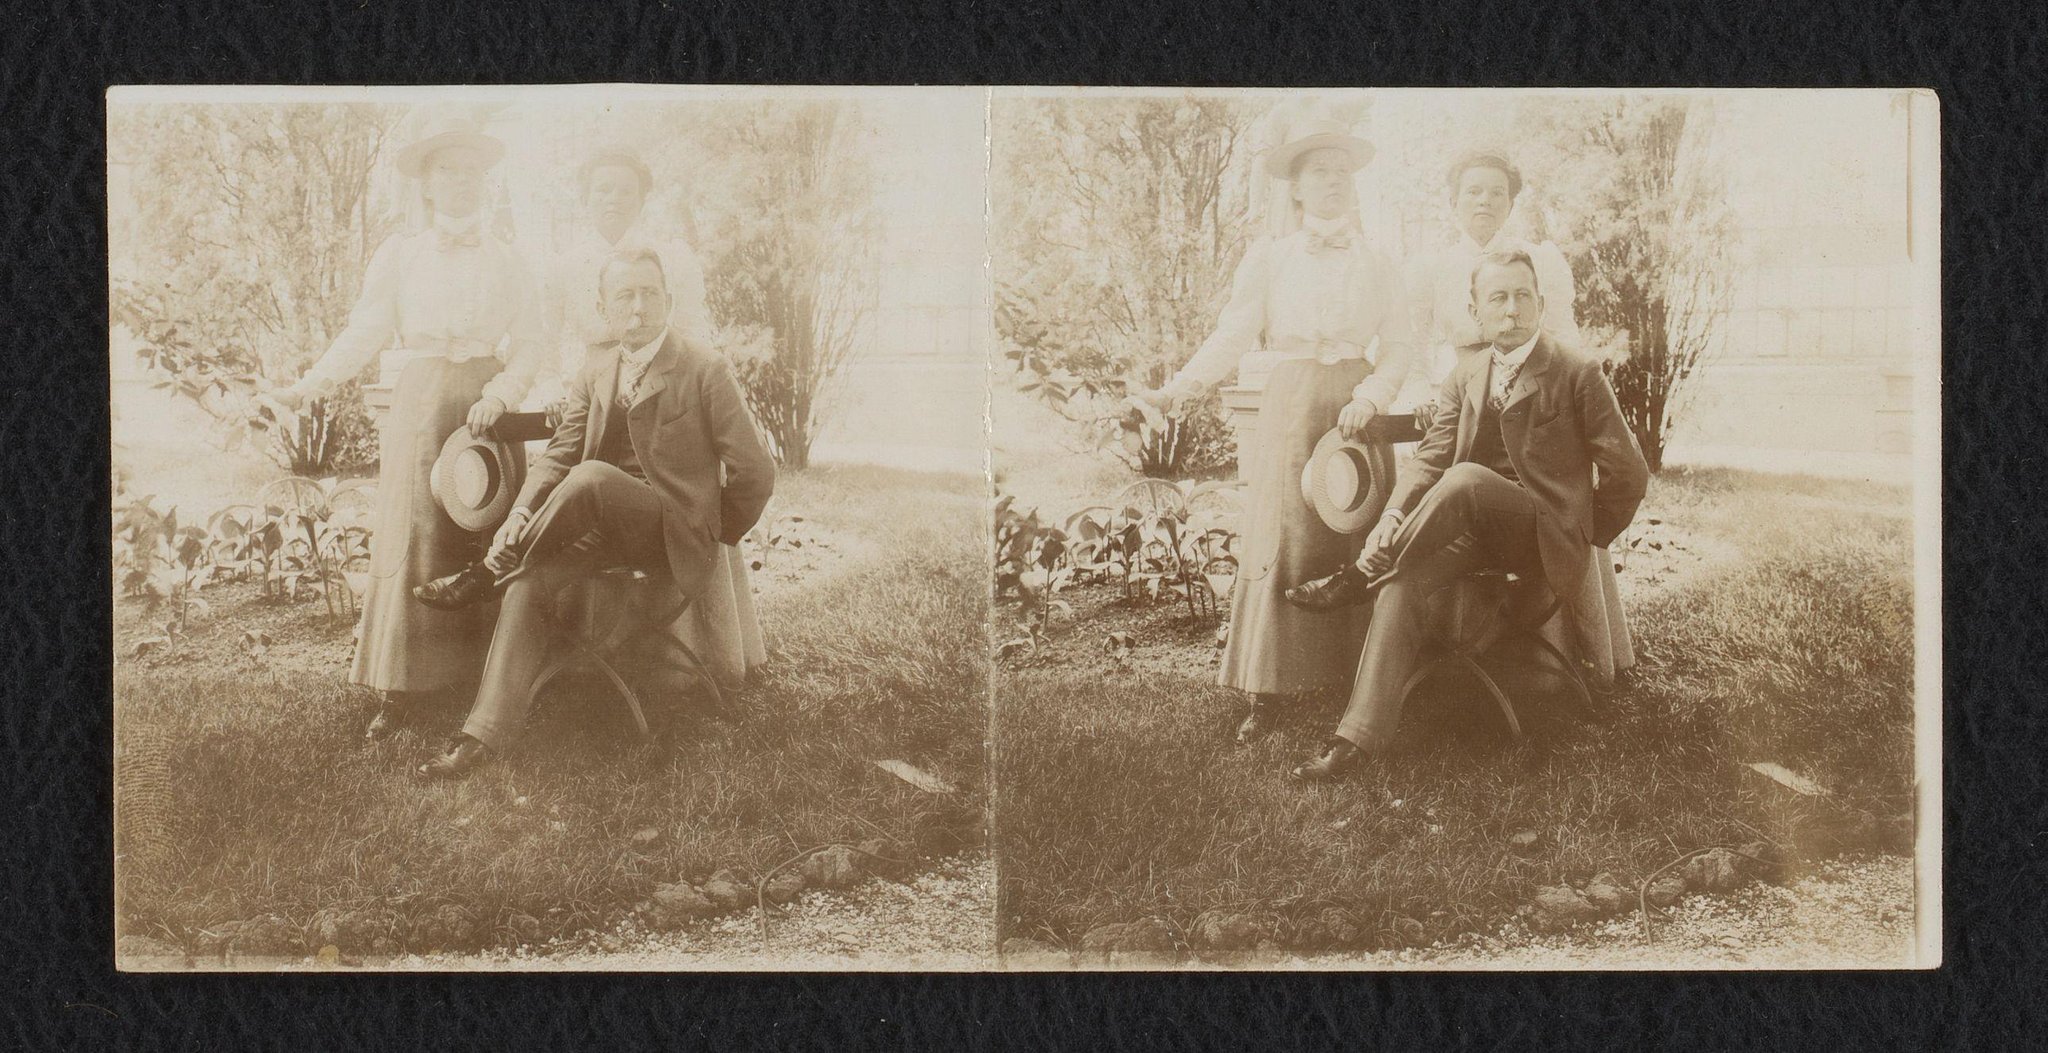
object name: stereograph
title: August, Margo en An Kessler in een tuin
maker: jean baptiste august kessler (1853-1900)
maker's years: 1853-1900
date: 1900-1906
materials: paper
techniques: collodion silver print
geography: netherlands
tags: margaretha jacoba johanna kessler-de lange (margo), naples, jean baptiste august kessler (1853-1900), family group, especially parents with their child(ren), historical persons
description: Uit envelop van Hendrik A. Matthes (1861 – 1919; Keizersgracht 756, Amsterdam), met opschrift van een van de kinderen van August Kessler (1853-1900): 'Photo's die Papaatje bij zich had.'